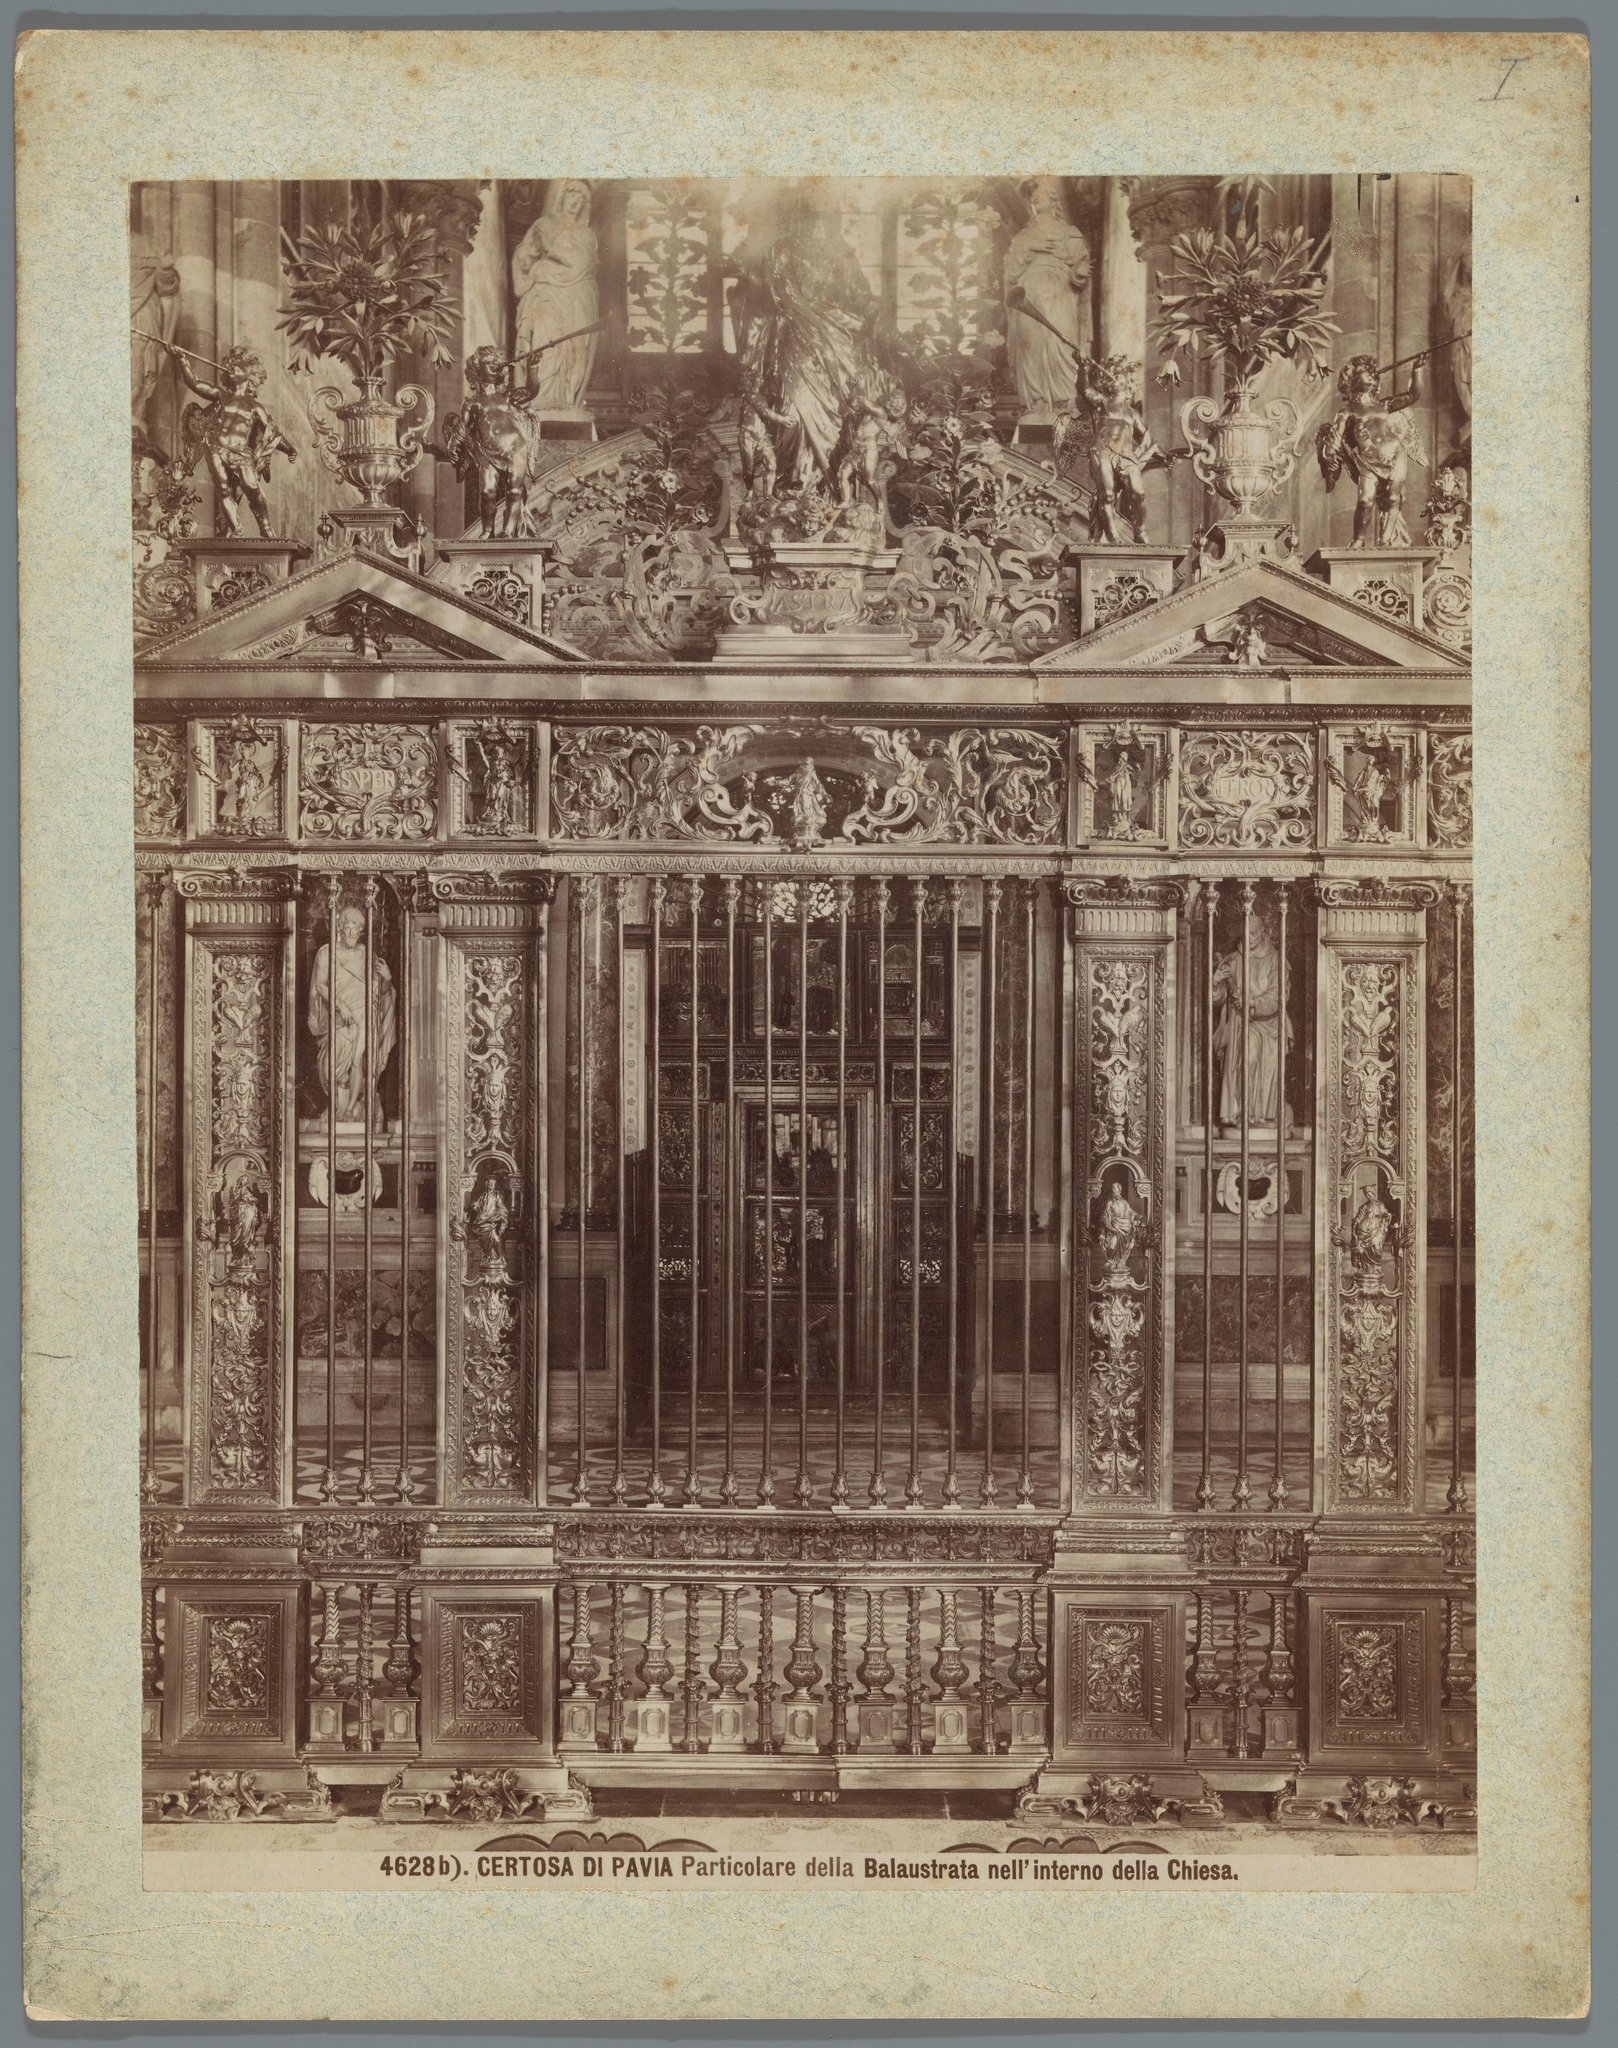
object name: photograph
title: CERTOSA DI PAVIA Particolare della Balaustrata nell'inferno della Chiesa.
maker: Anonymous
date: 1875-1900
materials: cardboard, photographic support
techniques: albumen print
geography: certosa di pavia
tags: balustrade, interior of church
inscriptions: collector's mark: Lugt 3937, number: ‘4628 b).’